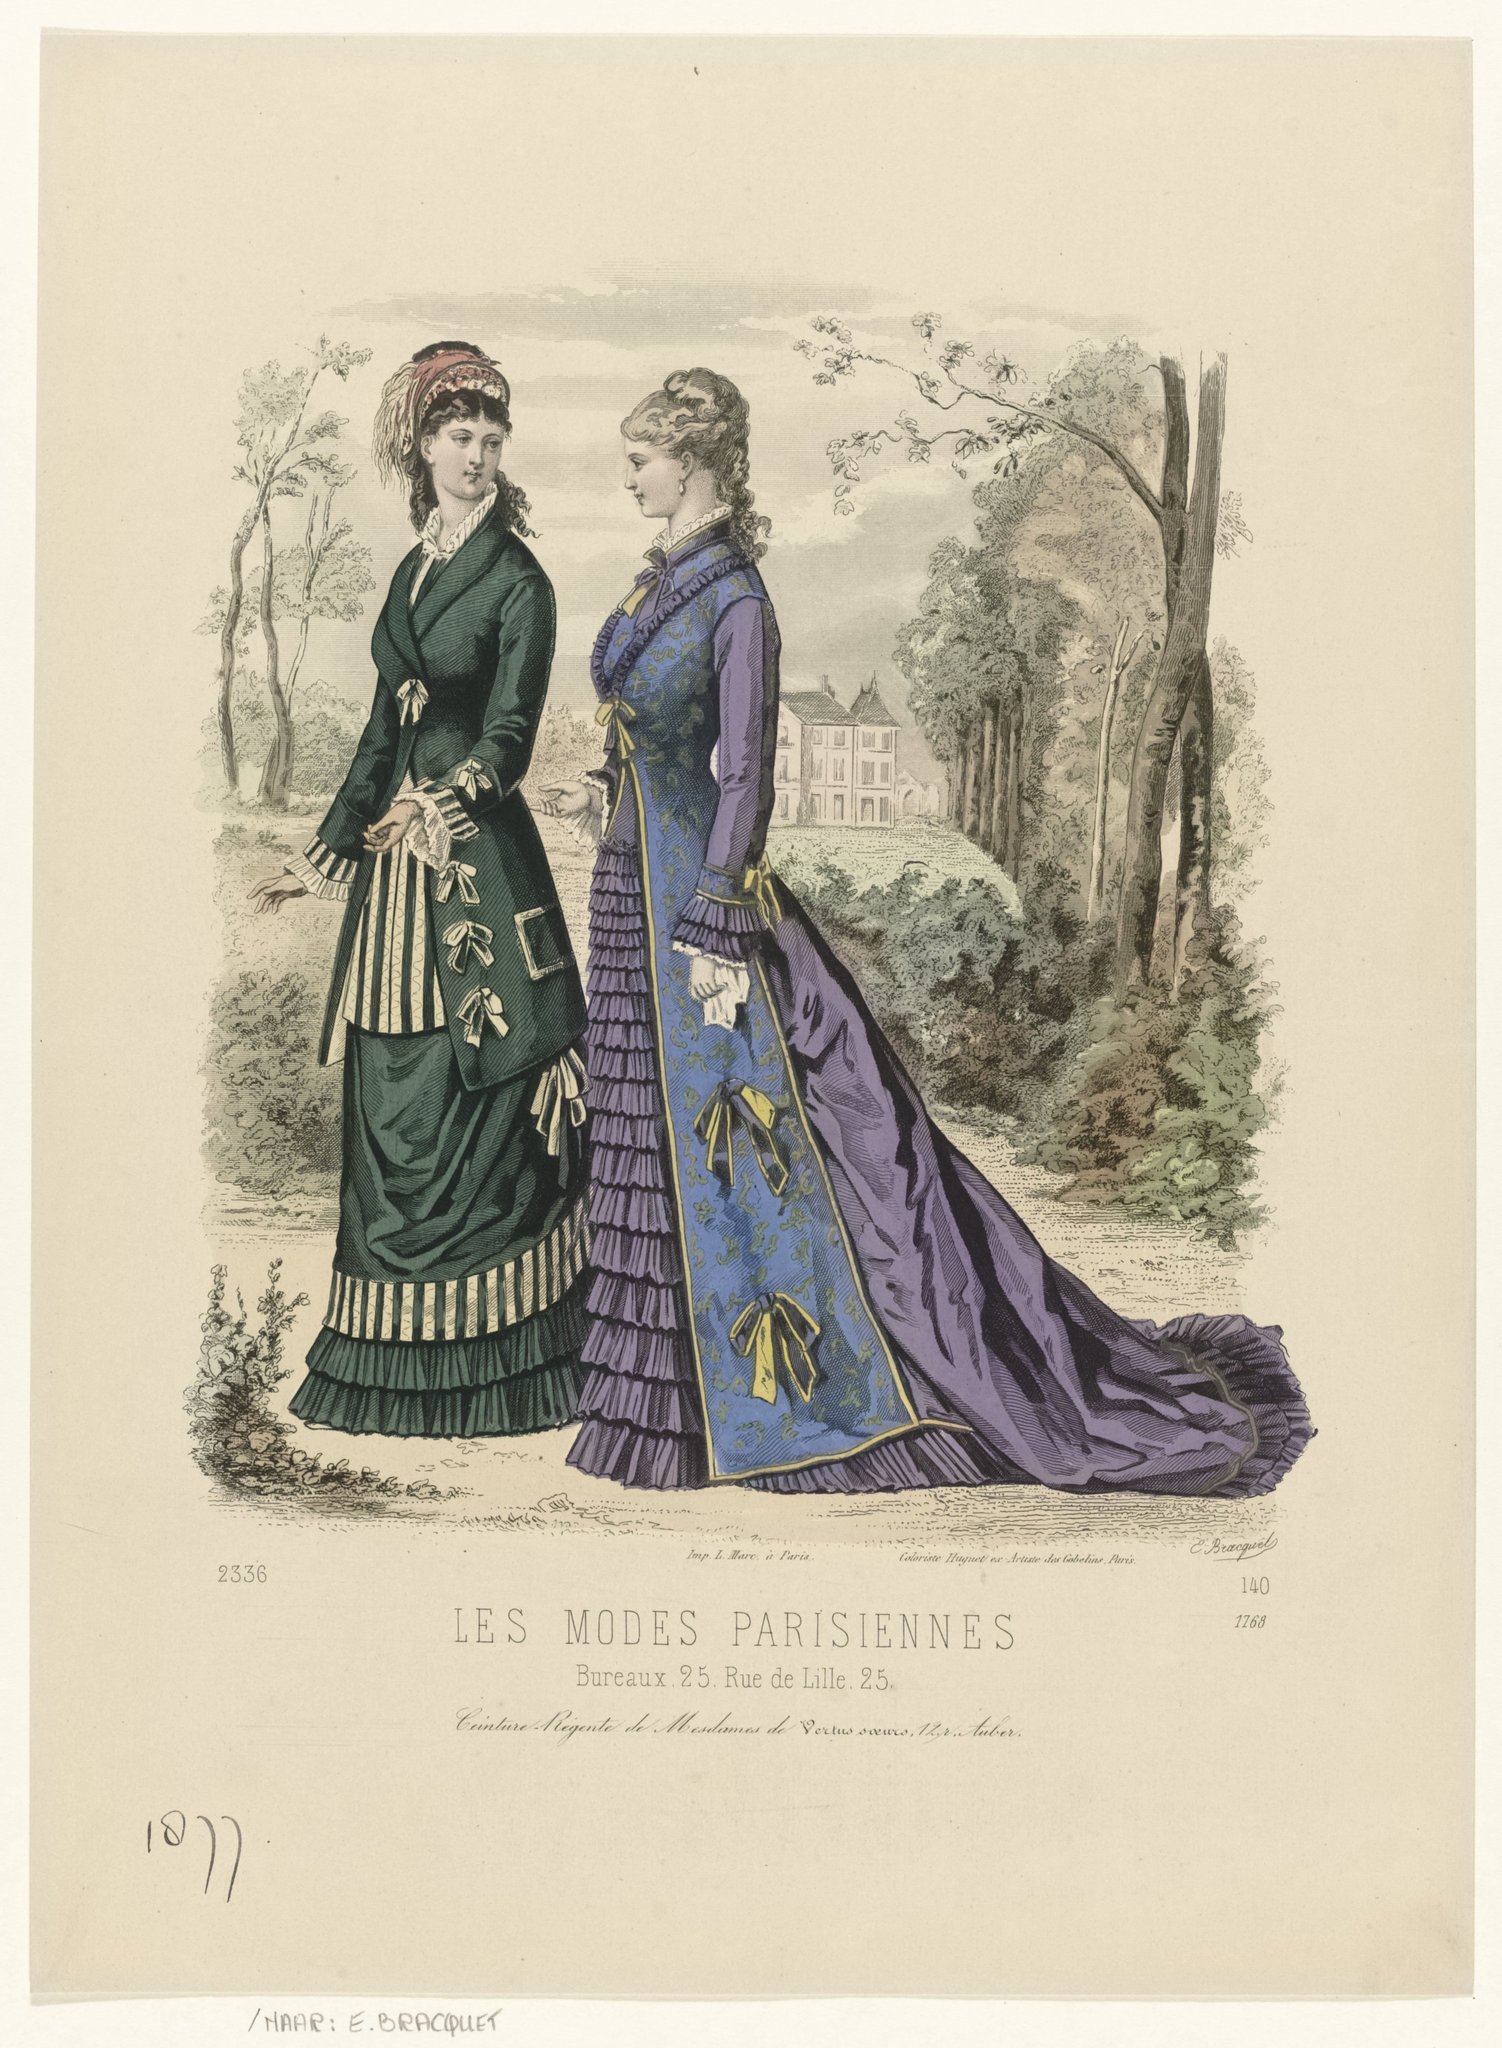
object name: fashion print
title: Les Modes Parisiennes, 1877, No. 1768 : Ceinture-Régente de Mesdames de Vertus soeurs, (...)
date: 1877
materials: paper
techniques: engraving, hand coloring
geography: paris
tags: bow (ornamental part of clothing) (+ women's clothes), handkerchief (+ women's clothes), dress, gown: walking dress (+ women's clothes), coat (+ women's clothes), fashion plates, head-gear: hat (+ women's clothes), skirt (+ women's clothes)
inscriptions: title: ‘LES MODES PARISIENNES’, address: ‘Bureaux, 25, Rue de Lille, 25’, caption: ‘Ceinture-Régente de Mesdames de Vertus soeurs, 12, r. Auber.’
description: Twee vrouwen wandelend in een tuin, op de achtergrond een landhuis. Onder de voorstelling een regel reclametekst voor de 'ceinture-Régente' van Mesdames de Vertus soeurs. Prent uit het modetijdschrift Les Modes Parisiennes (1843-1885).